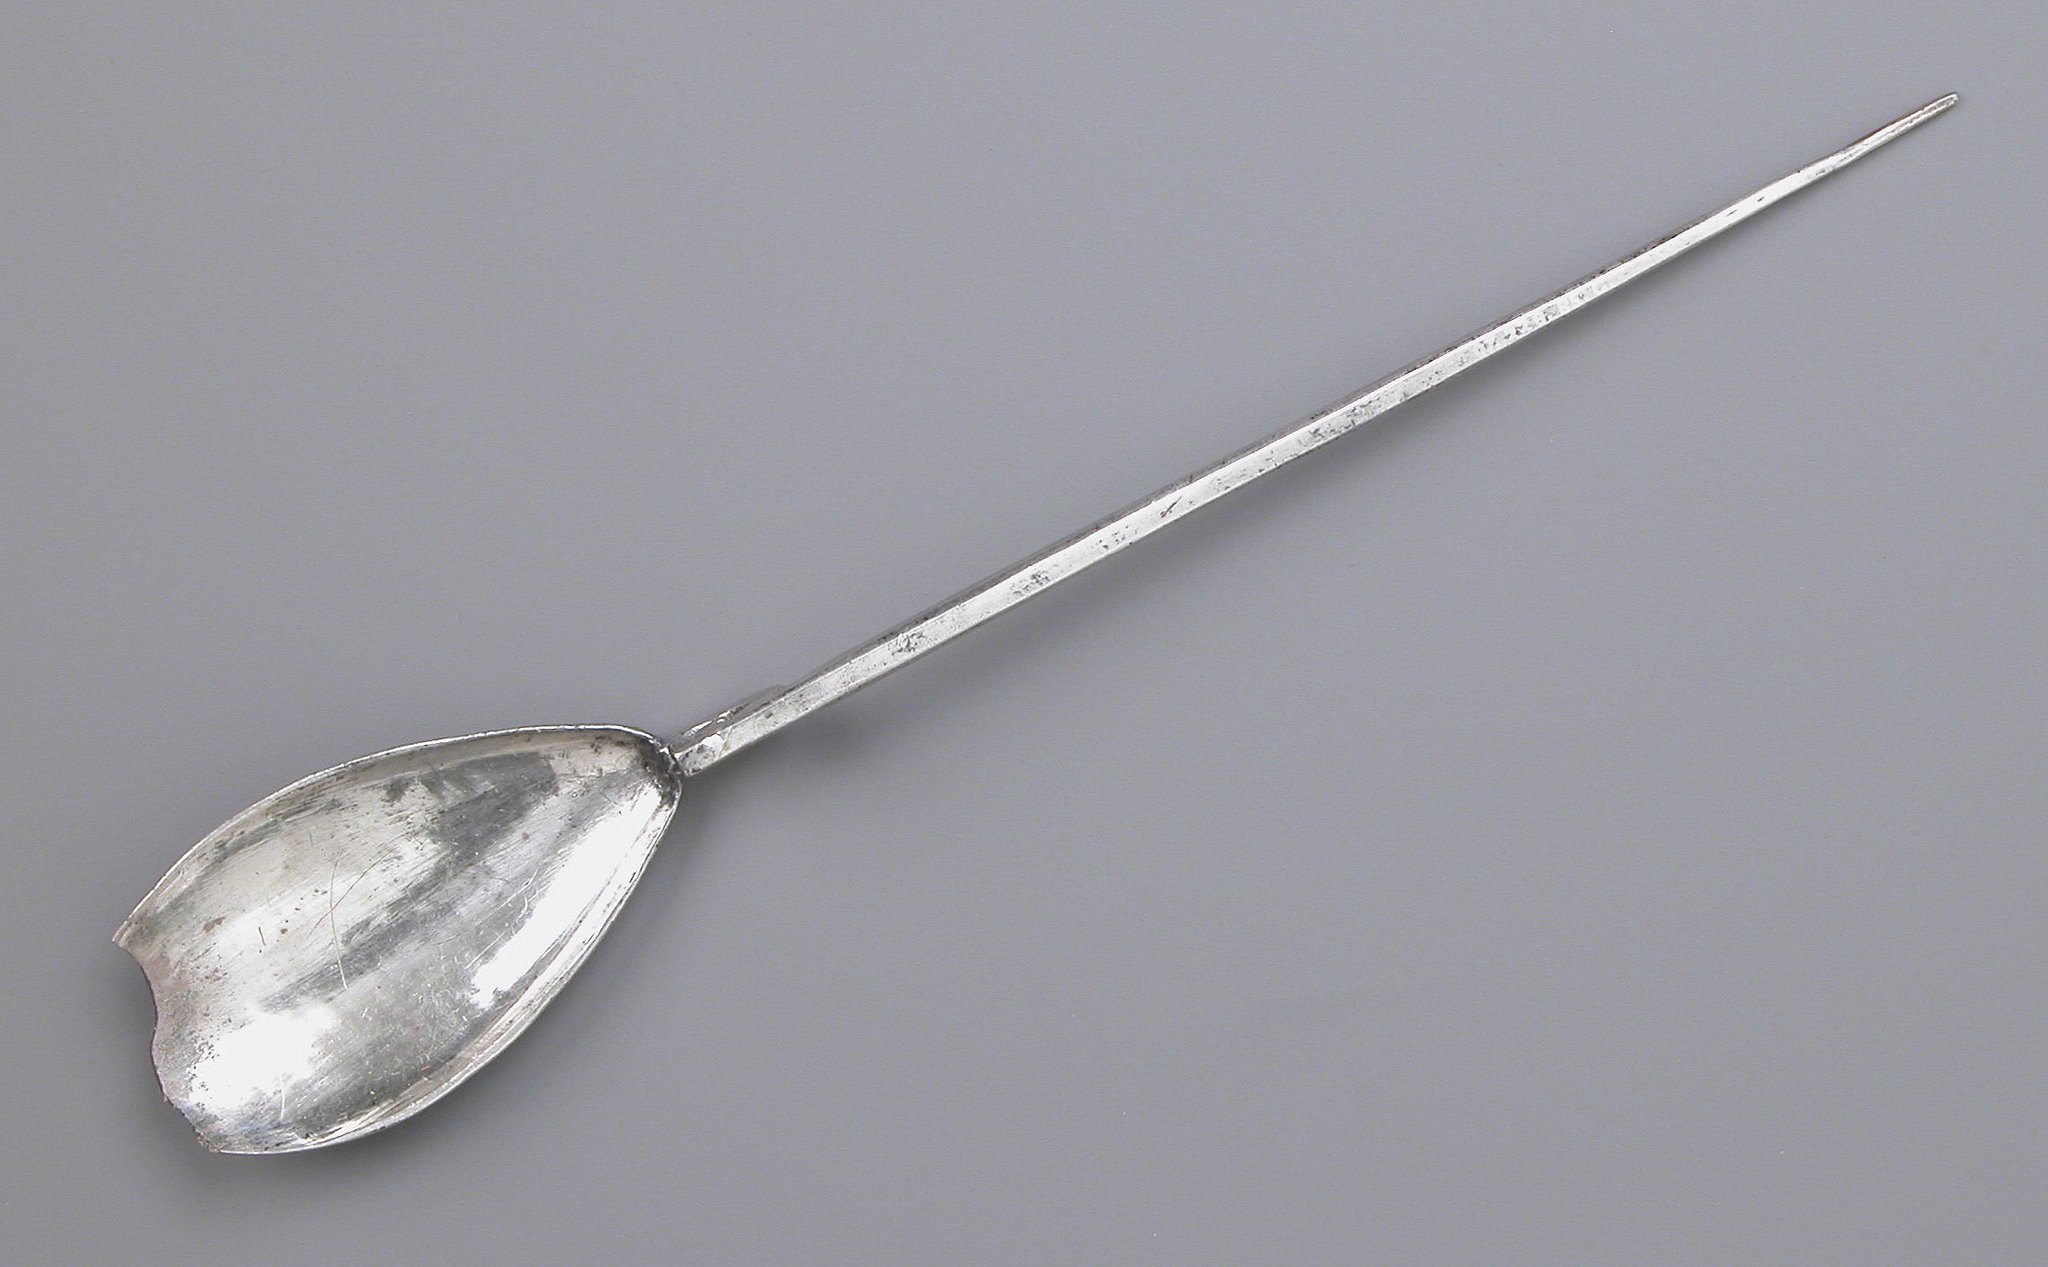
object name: spoon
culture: coptic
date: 301-700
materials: silver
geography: egypt